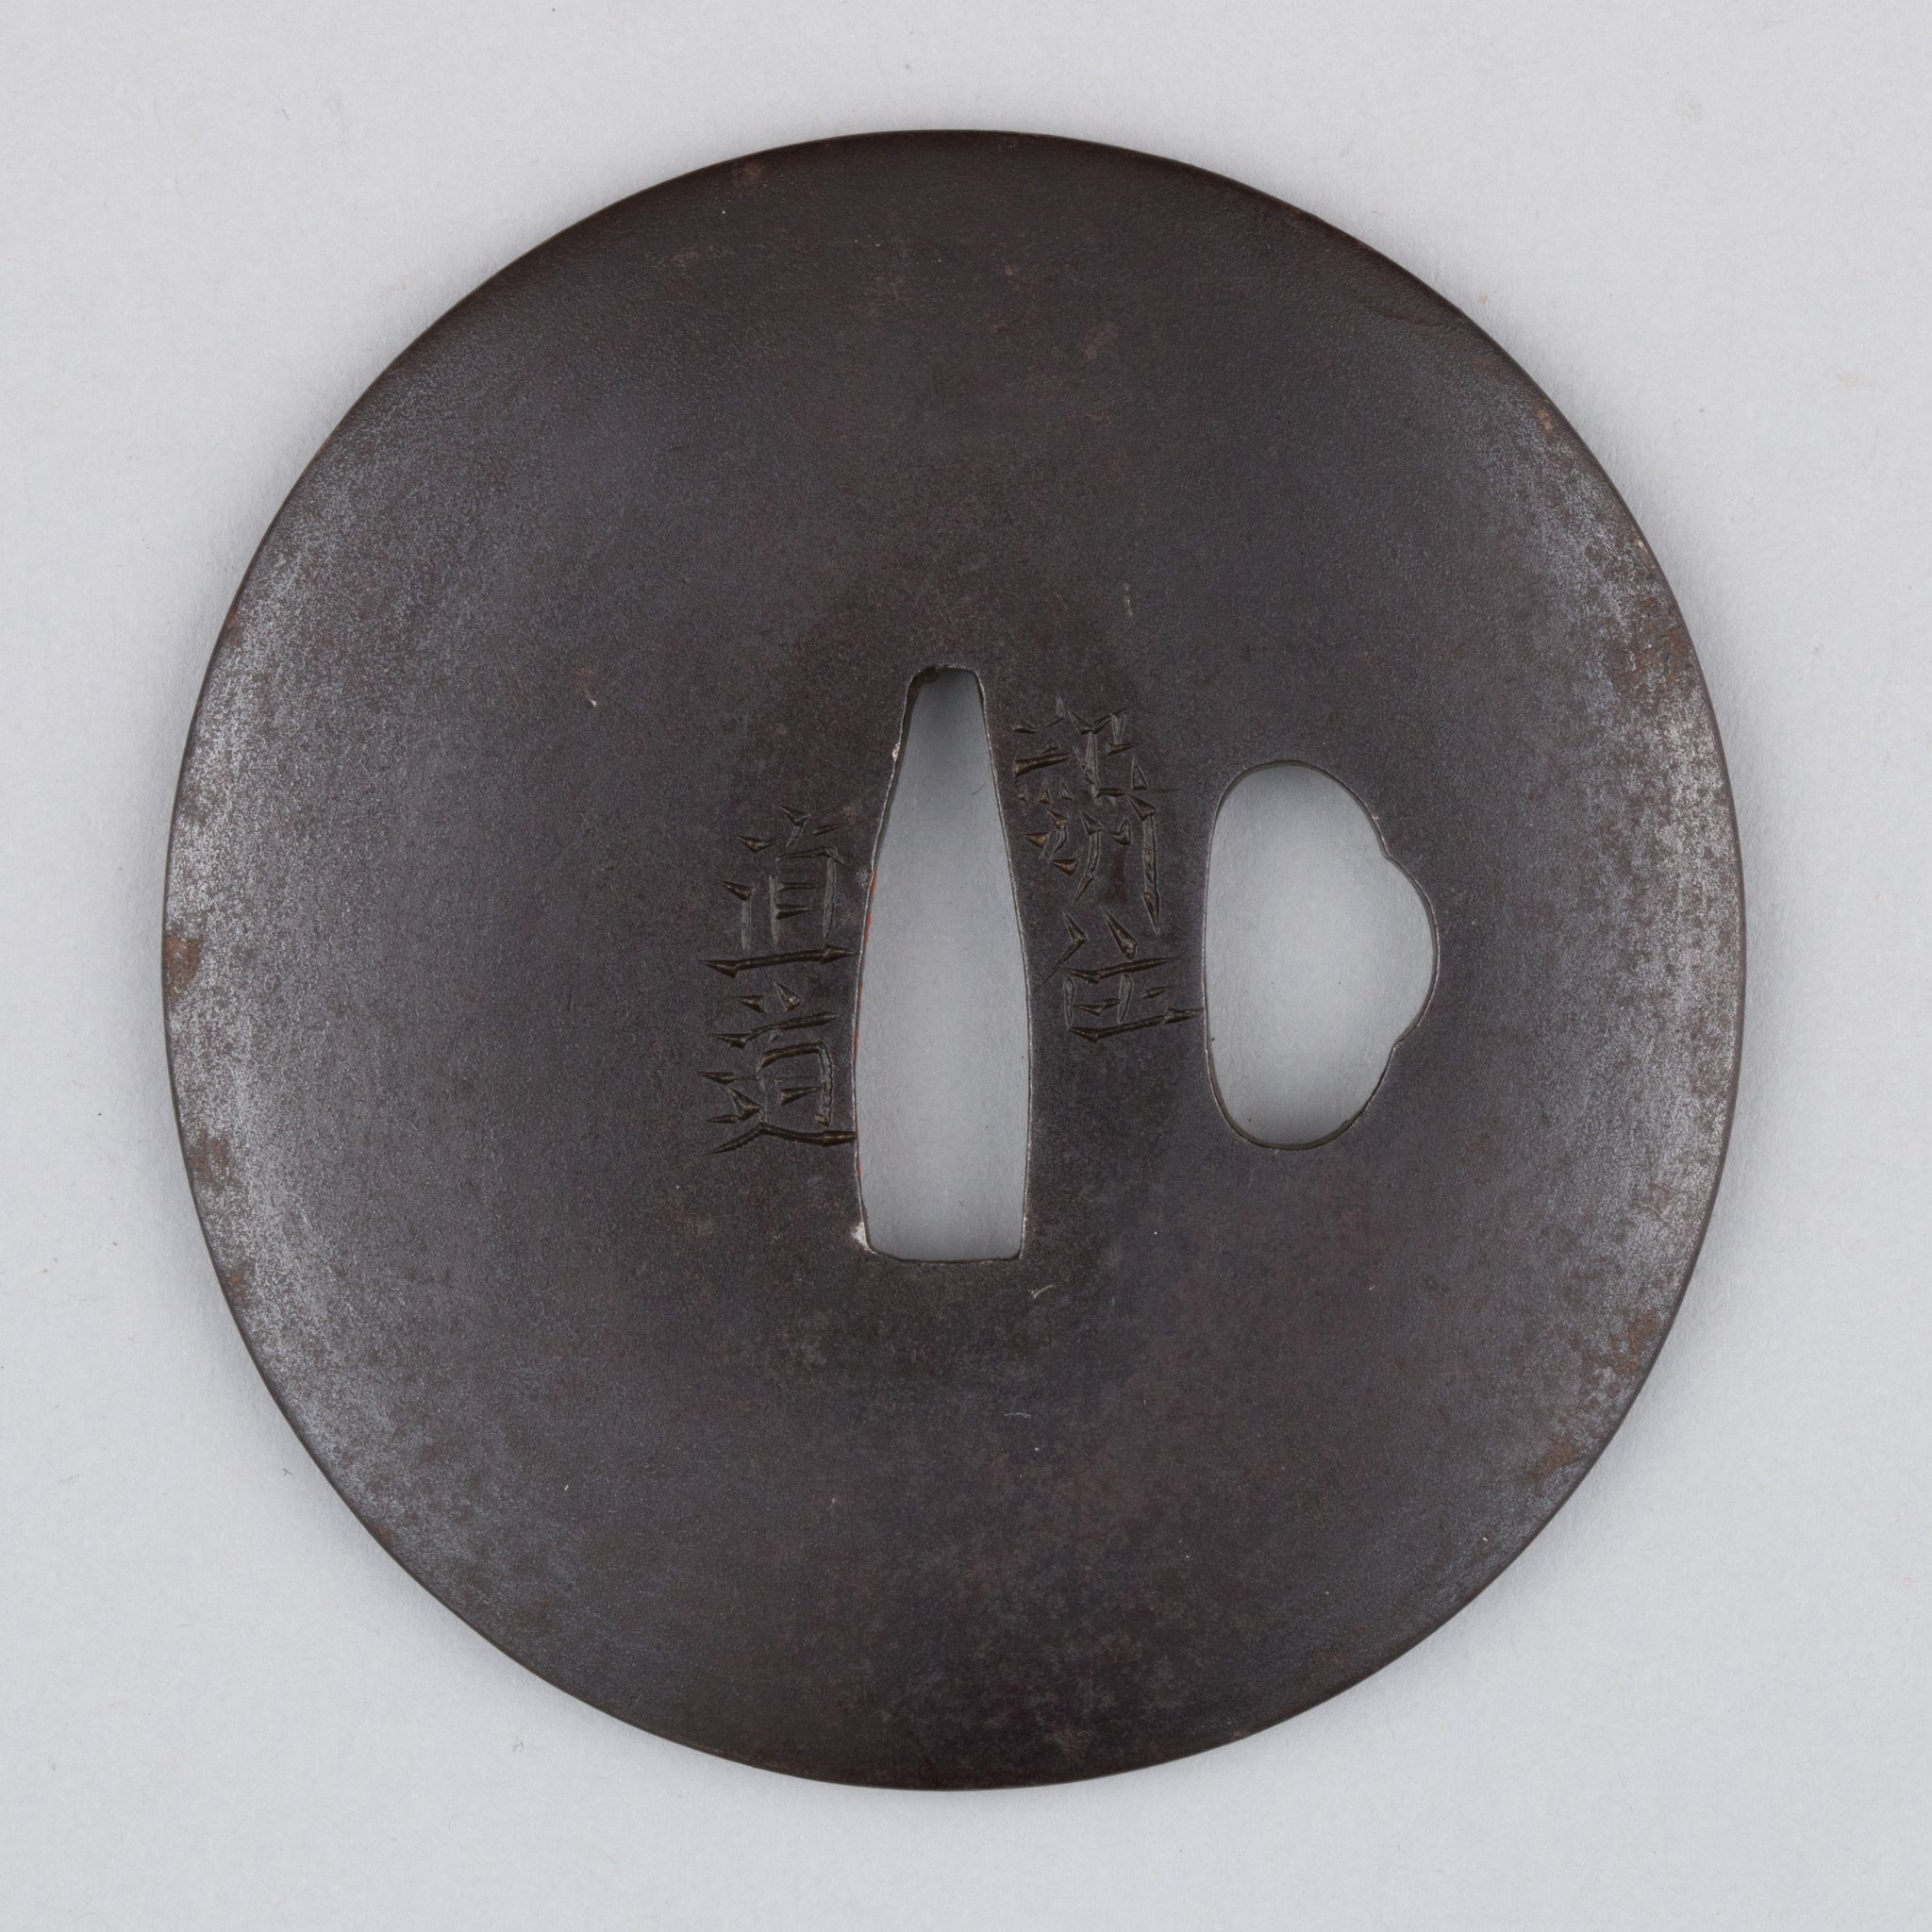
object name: sword guard tsuba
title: Sword Guard (Tsuba)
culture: japanese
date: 1701-1800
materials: copper, iron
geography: japan